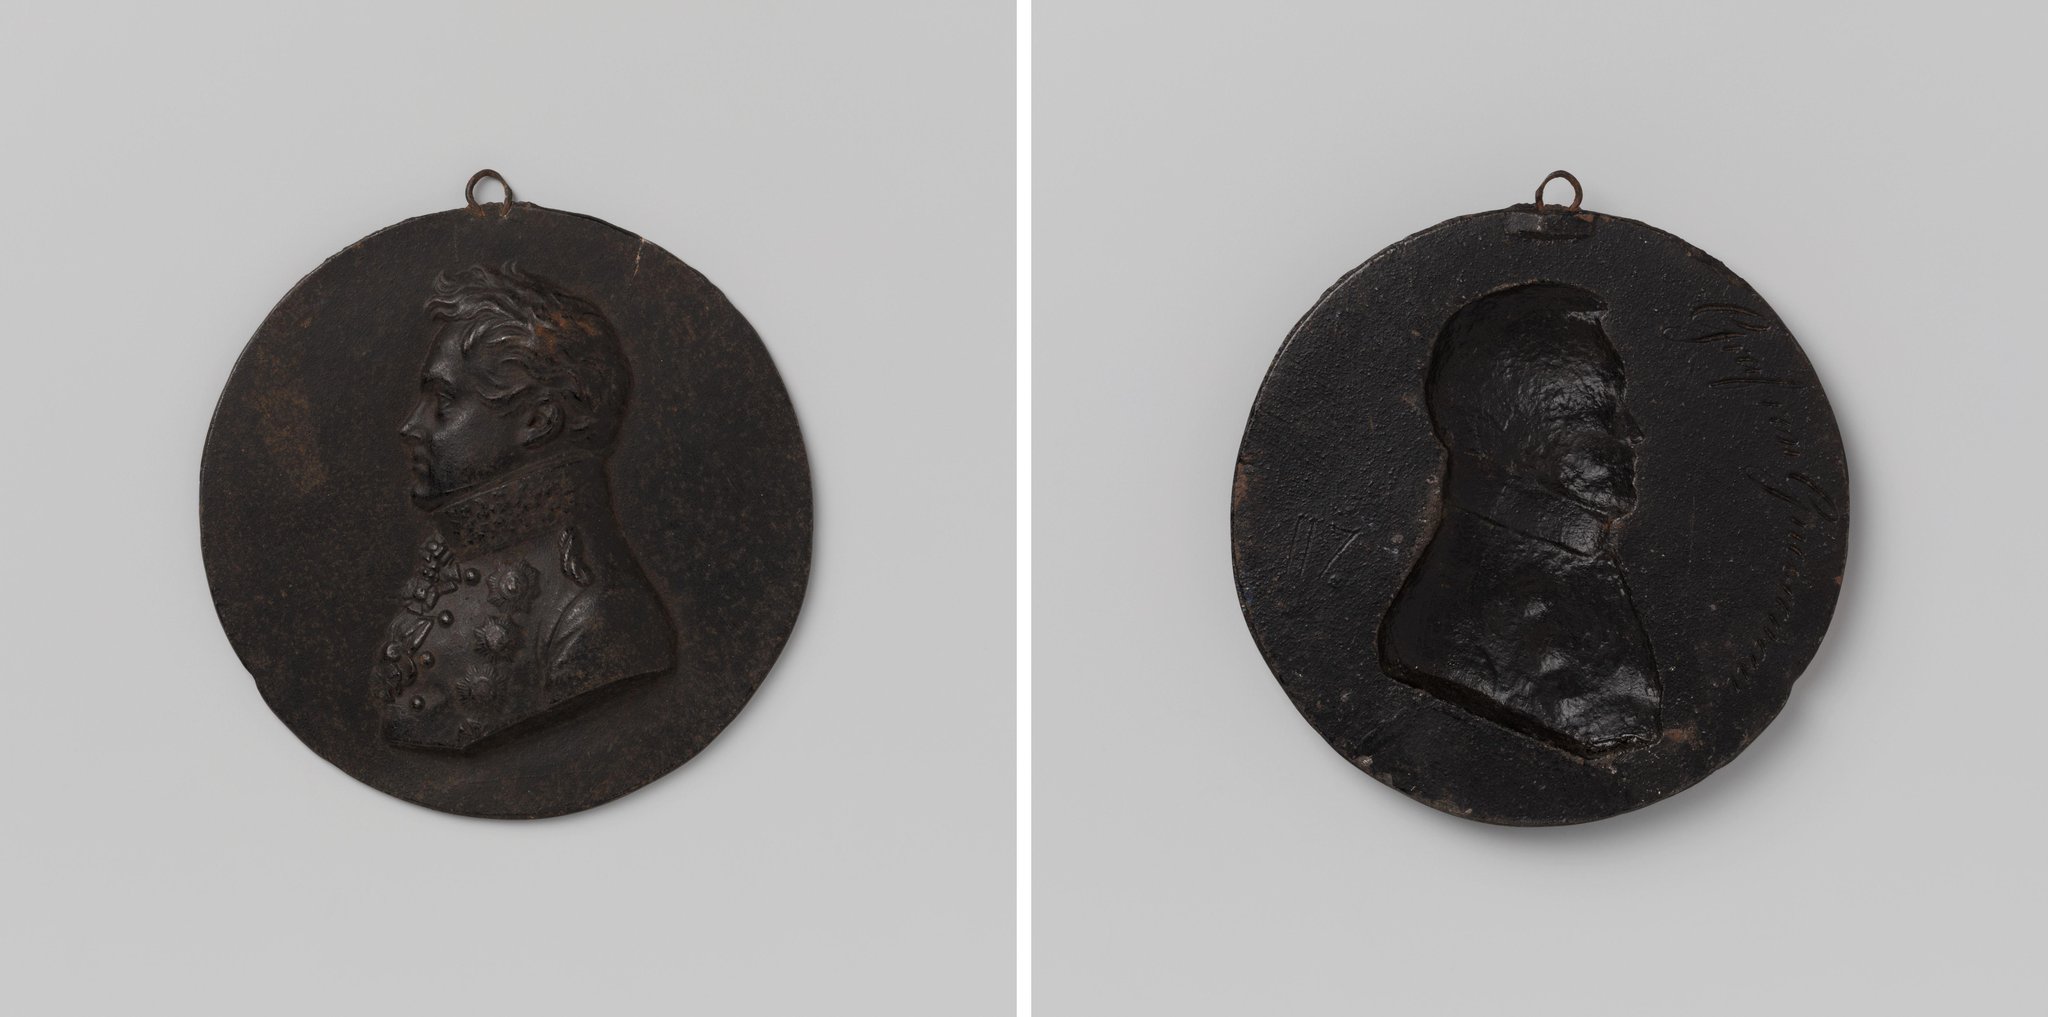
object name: plaque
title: Portret van graaf van Gneisenau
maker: leonhard posch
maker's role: sculptor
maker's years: 1750-1831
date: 1825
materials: iron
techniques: casting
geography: berlin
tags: berlin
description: IJzeren penning. Voorzijde: borststuk man. Keerzijde: naam.